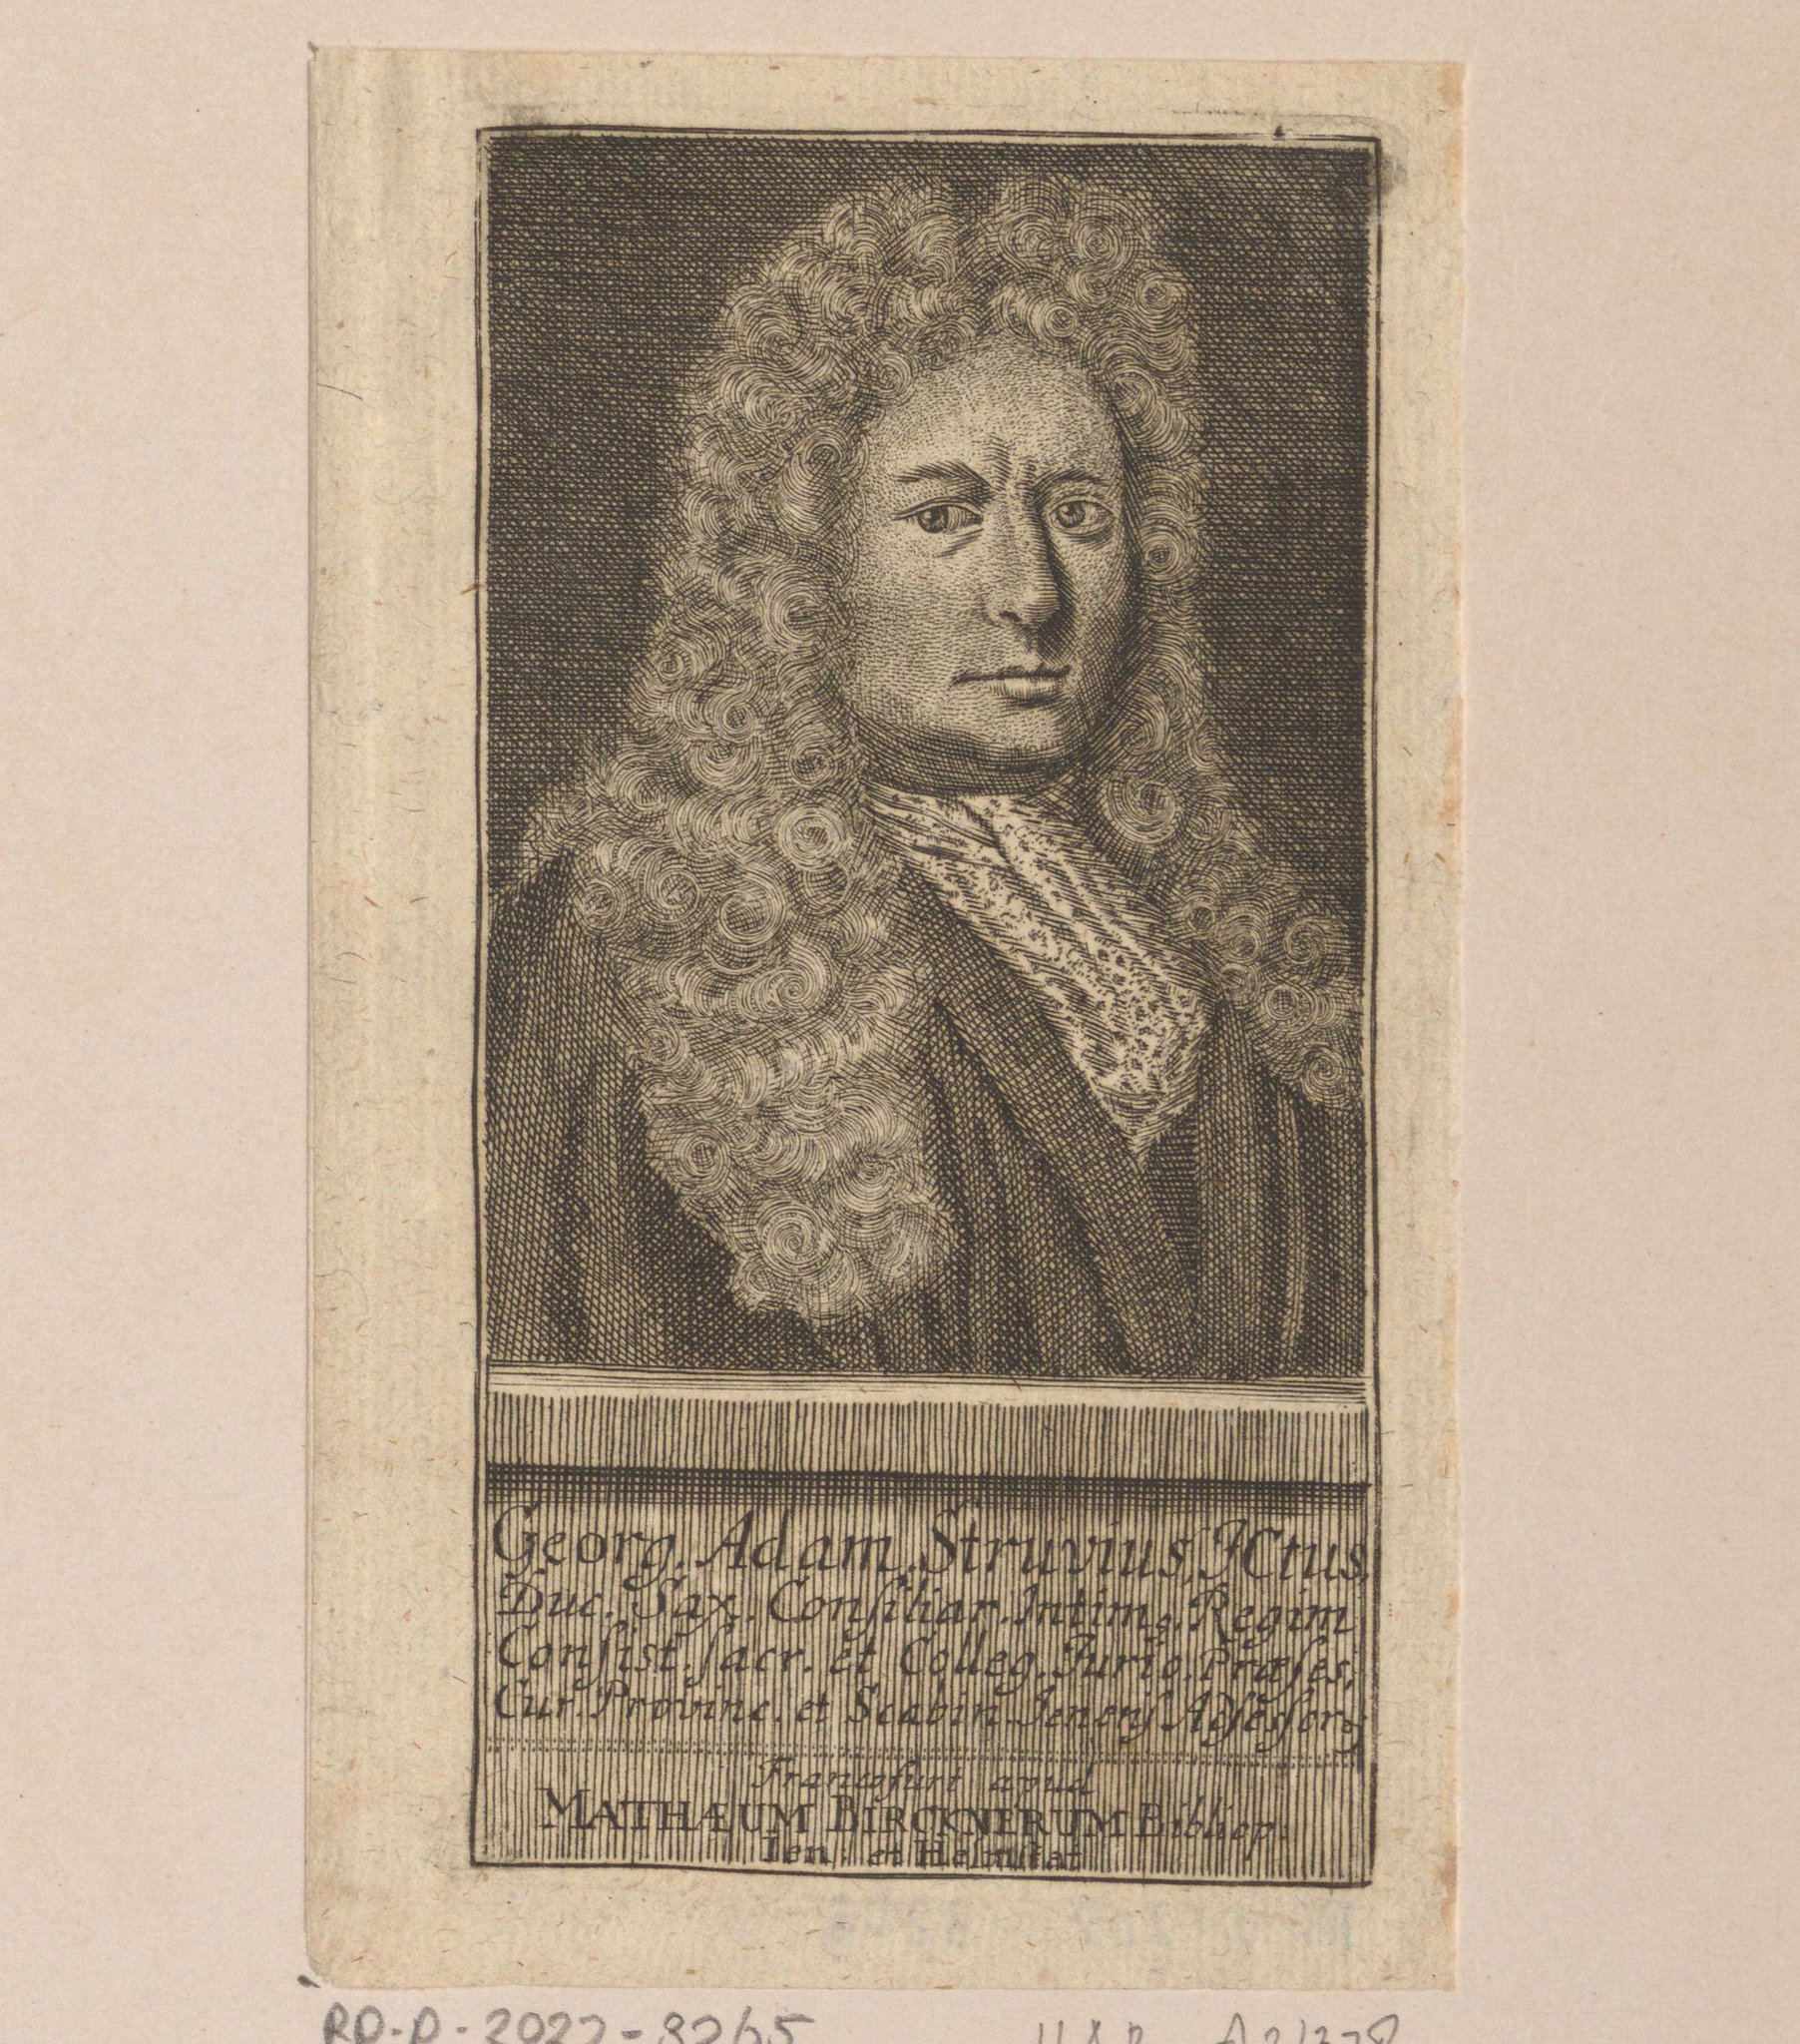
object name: print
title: Portret van Georg Adam Struve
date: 1660-1709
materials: paper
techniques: engraving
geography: jena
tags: historical persons, lawyer, attorney at law, professor